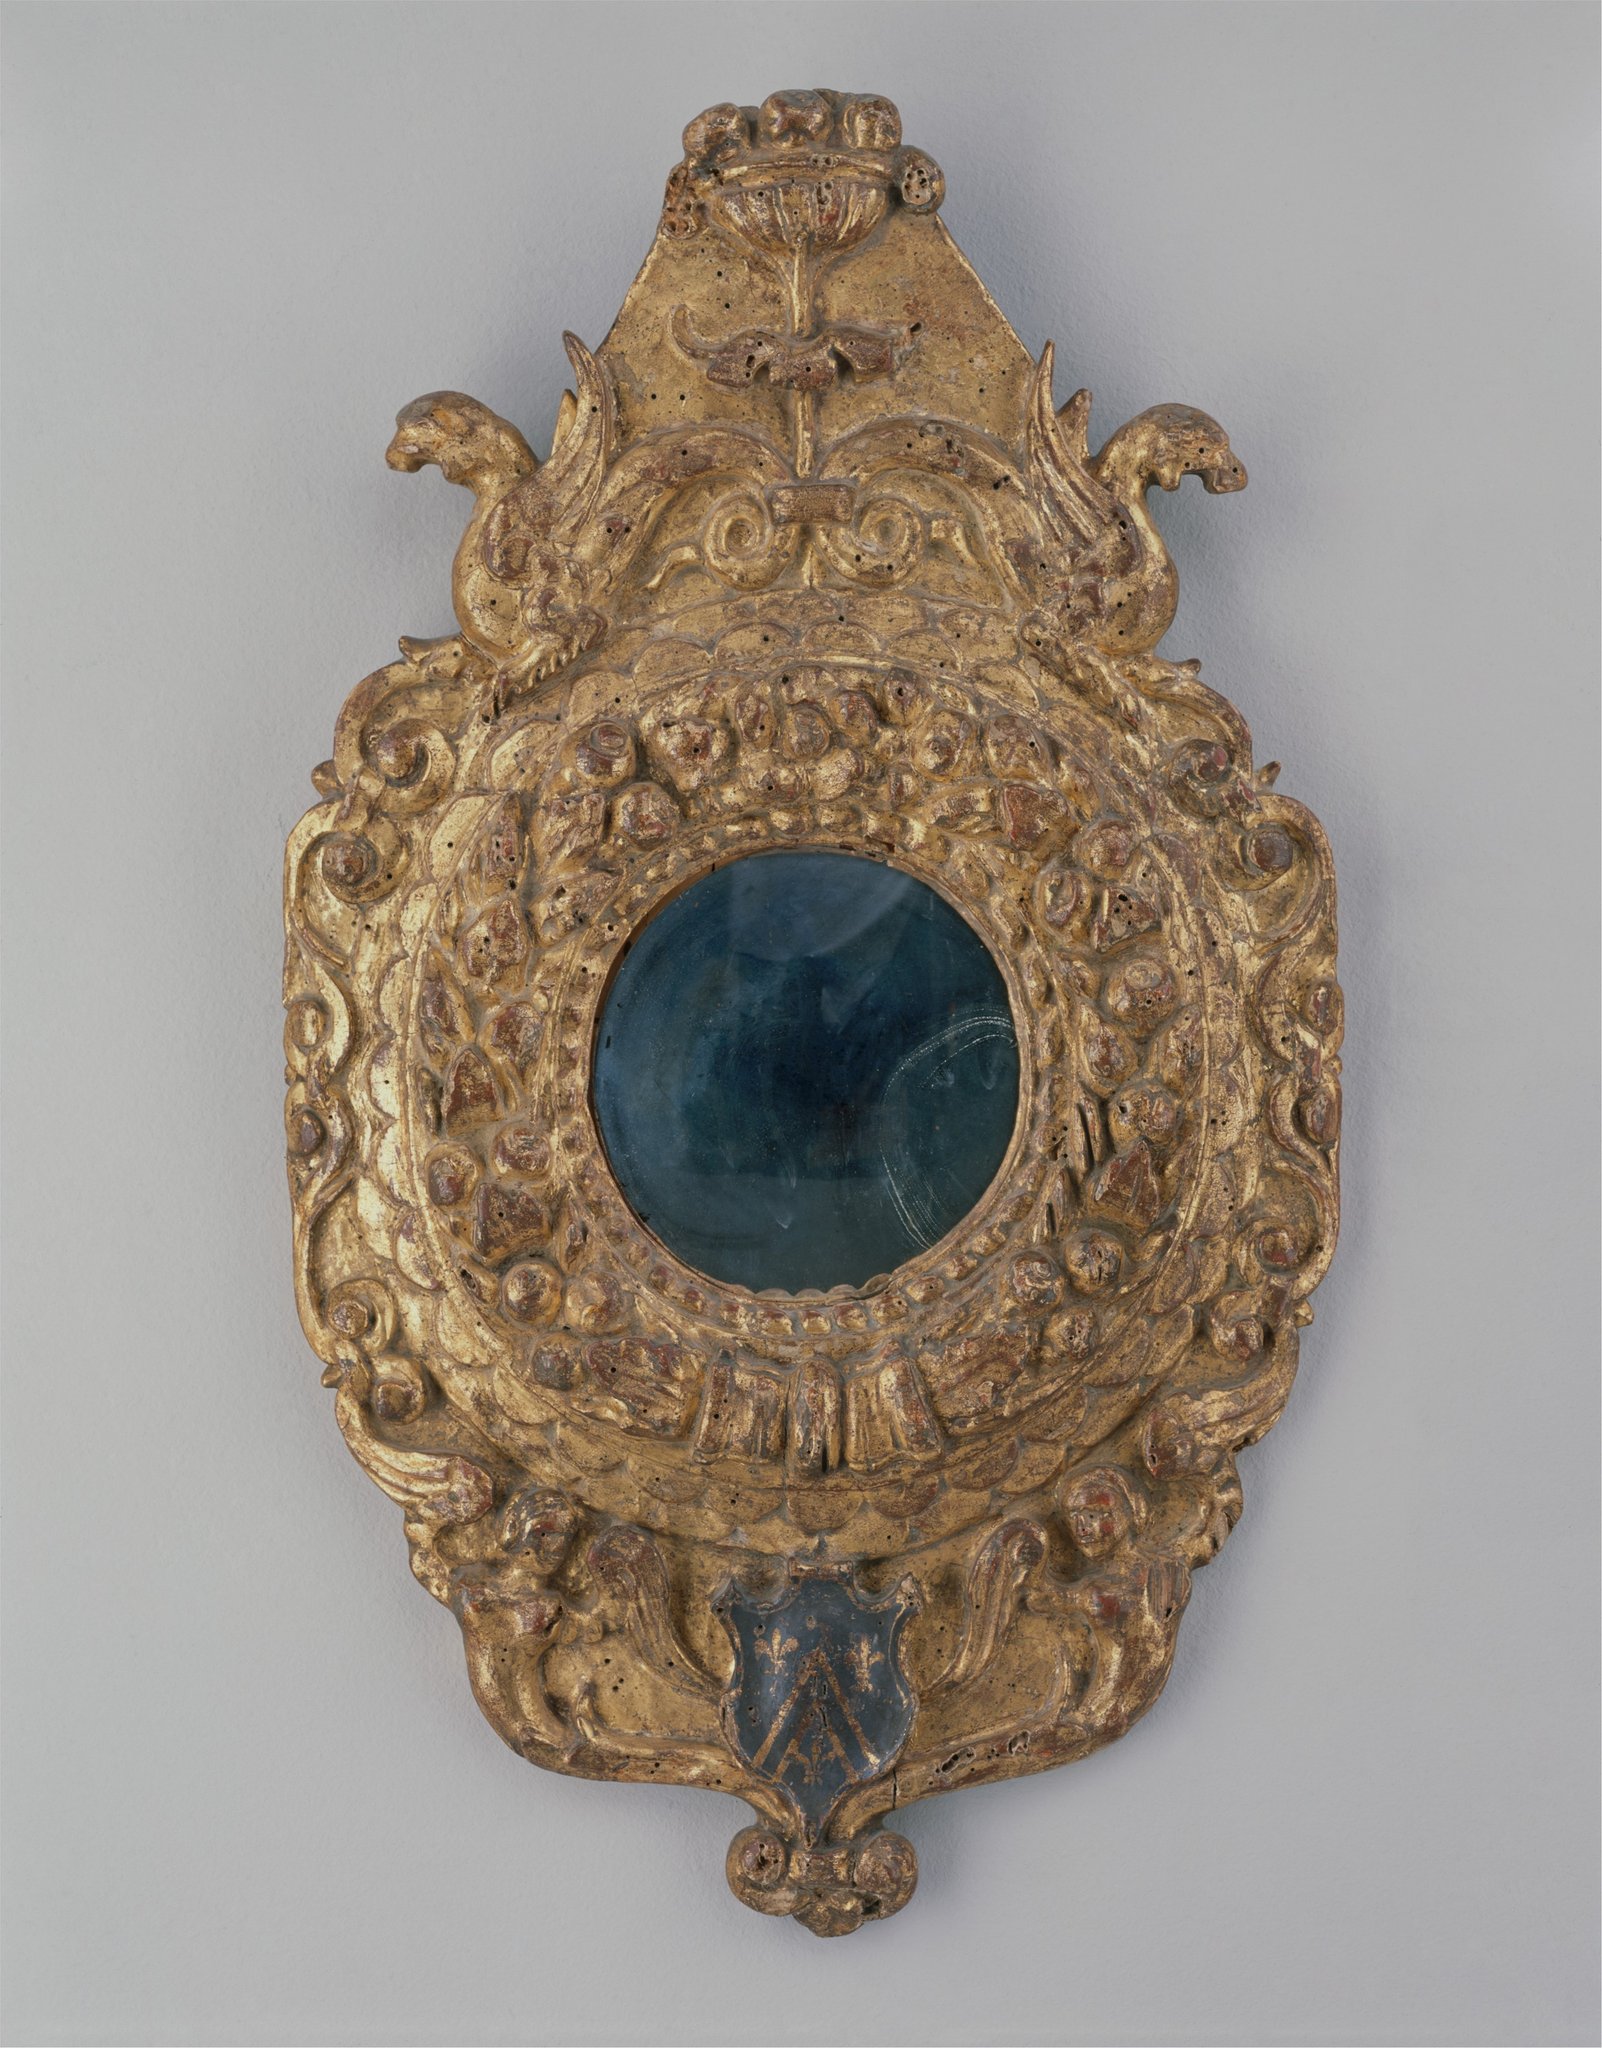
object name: tondo mirror frame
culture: italian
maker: italian, siena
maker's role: artist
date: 1490-1500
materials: gilt, wood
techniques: carving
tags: birds,coat of arms